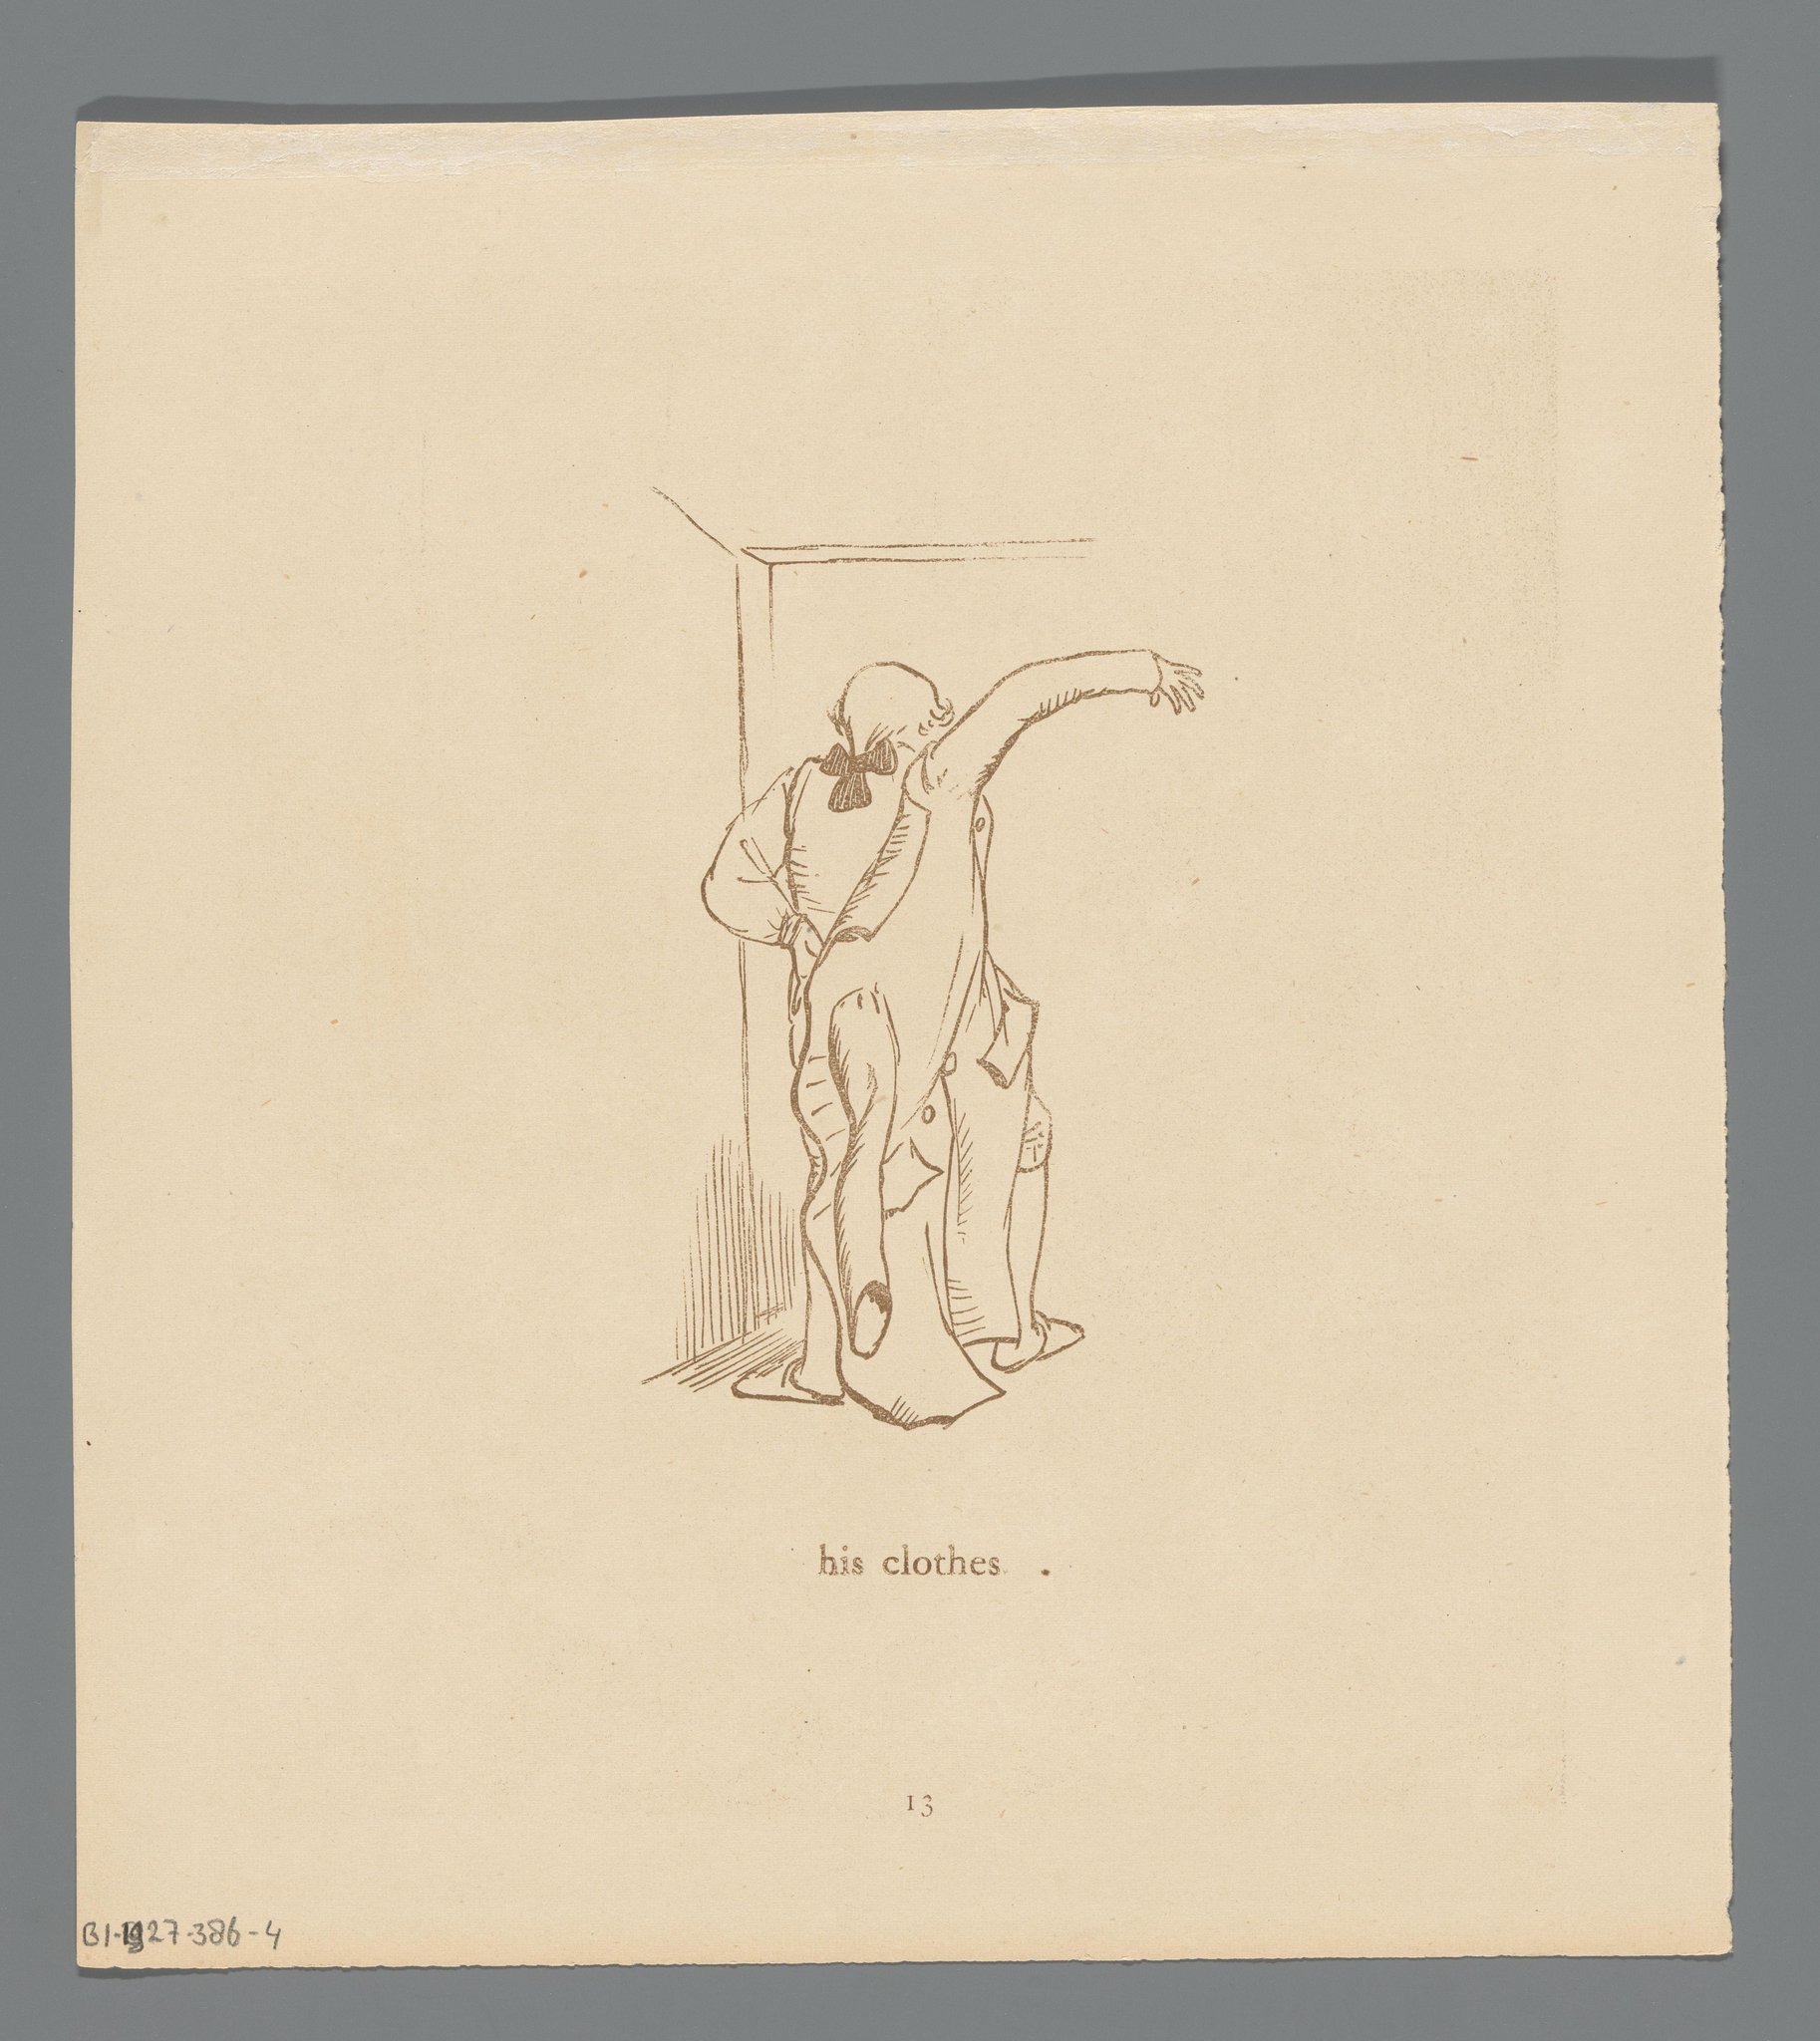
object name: book illustration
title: Man trekt zijn jas aan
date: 1879-1927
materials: paper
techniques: letterpress printing, engraving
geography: london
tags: coat, adult man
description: Prent uit: Goldsmith, Oliver. Elegy on a mad dog. Londen: George Routledge & Sons, 1879. Of uit een later gepubliceerde uitgave waarin vier verhalen (waaronder 'Elegy on a mad dog') zijn gebundeld.